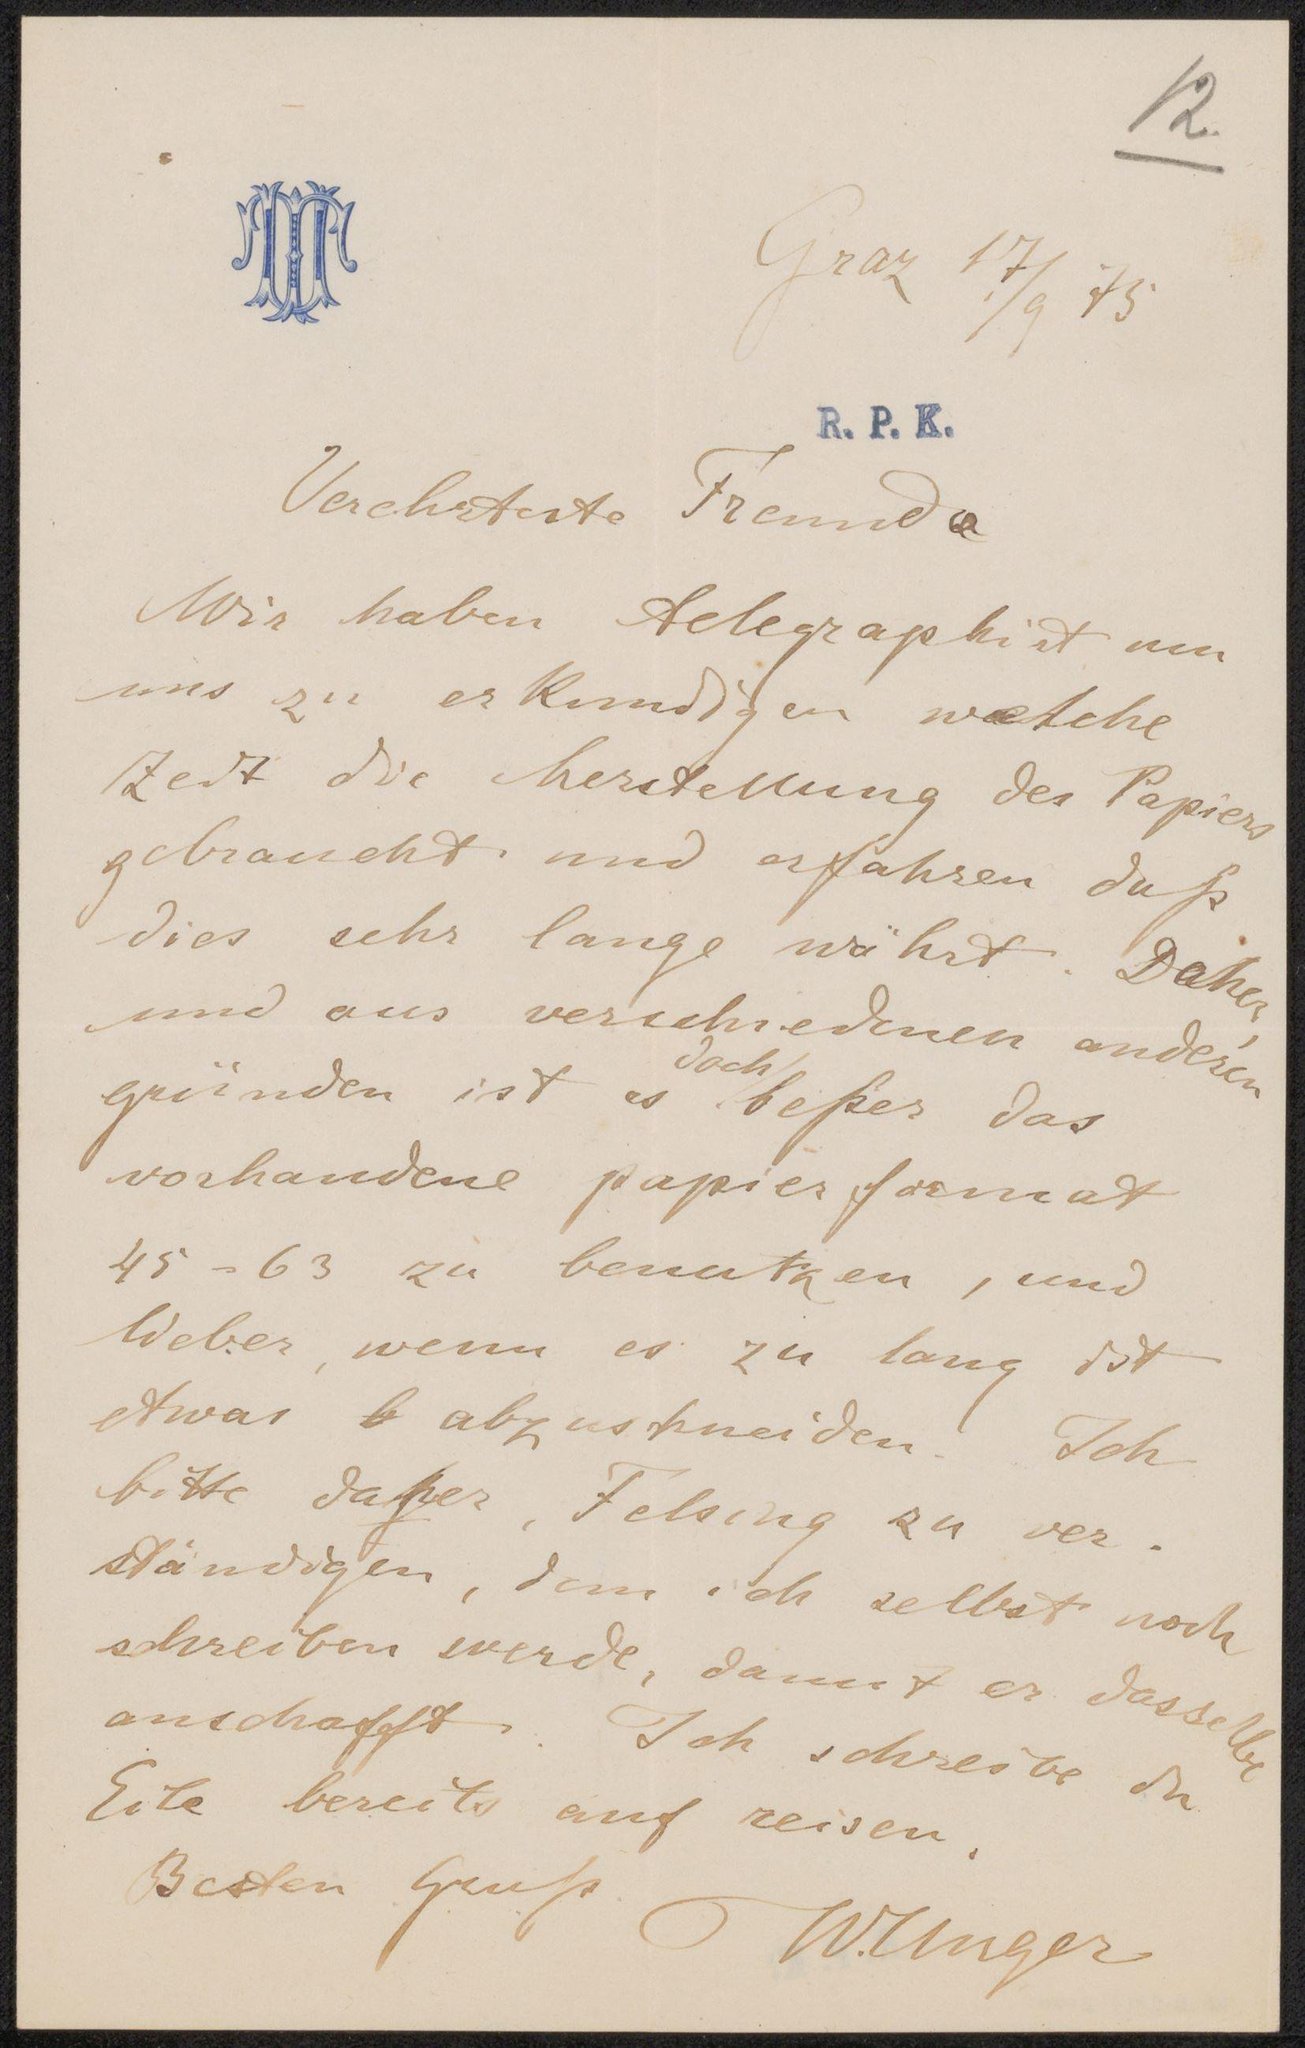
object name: letter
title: Brief aan Frans Buffa en Zonen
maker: william unger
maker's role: draughtsman, painter, print maker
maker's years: 1837-1932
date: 1875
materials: ink, paper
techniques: pen, printing, writing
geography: graz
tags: georg friedrich felsing, publisher, printed matter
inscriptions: collector's mark: Lugt 2233